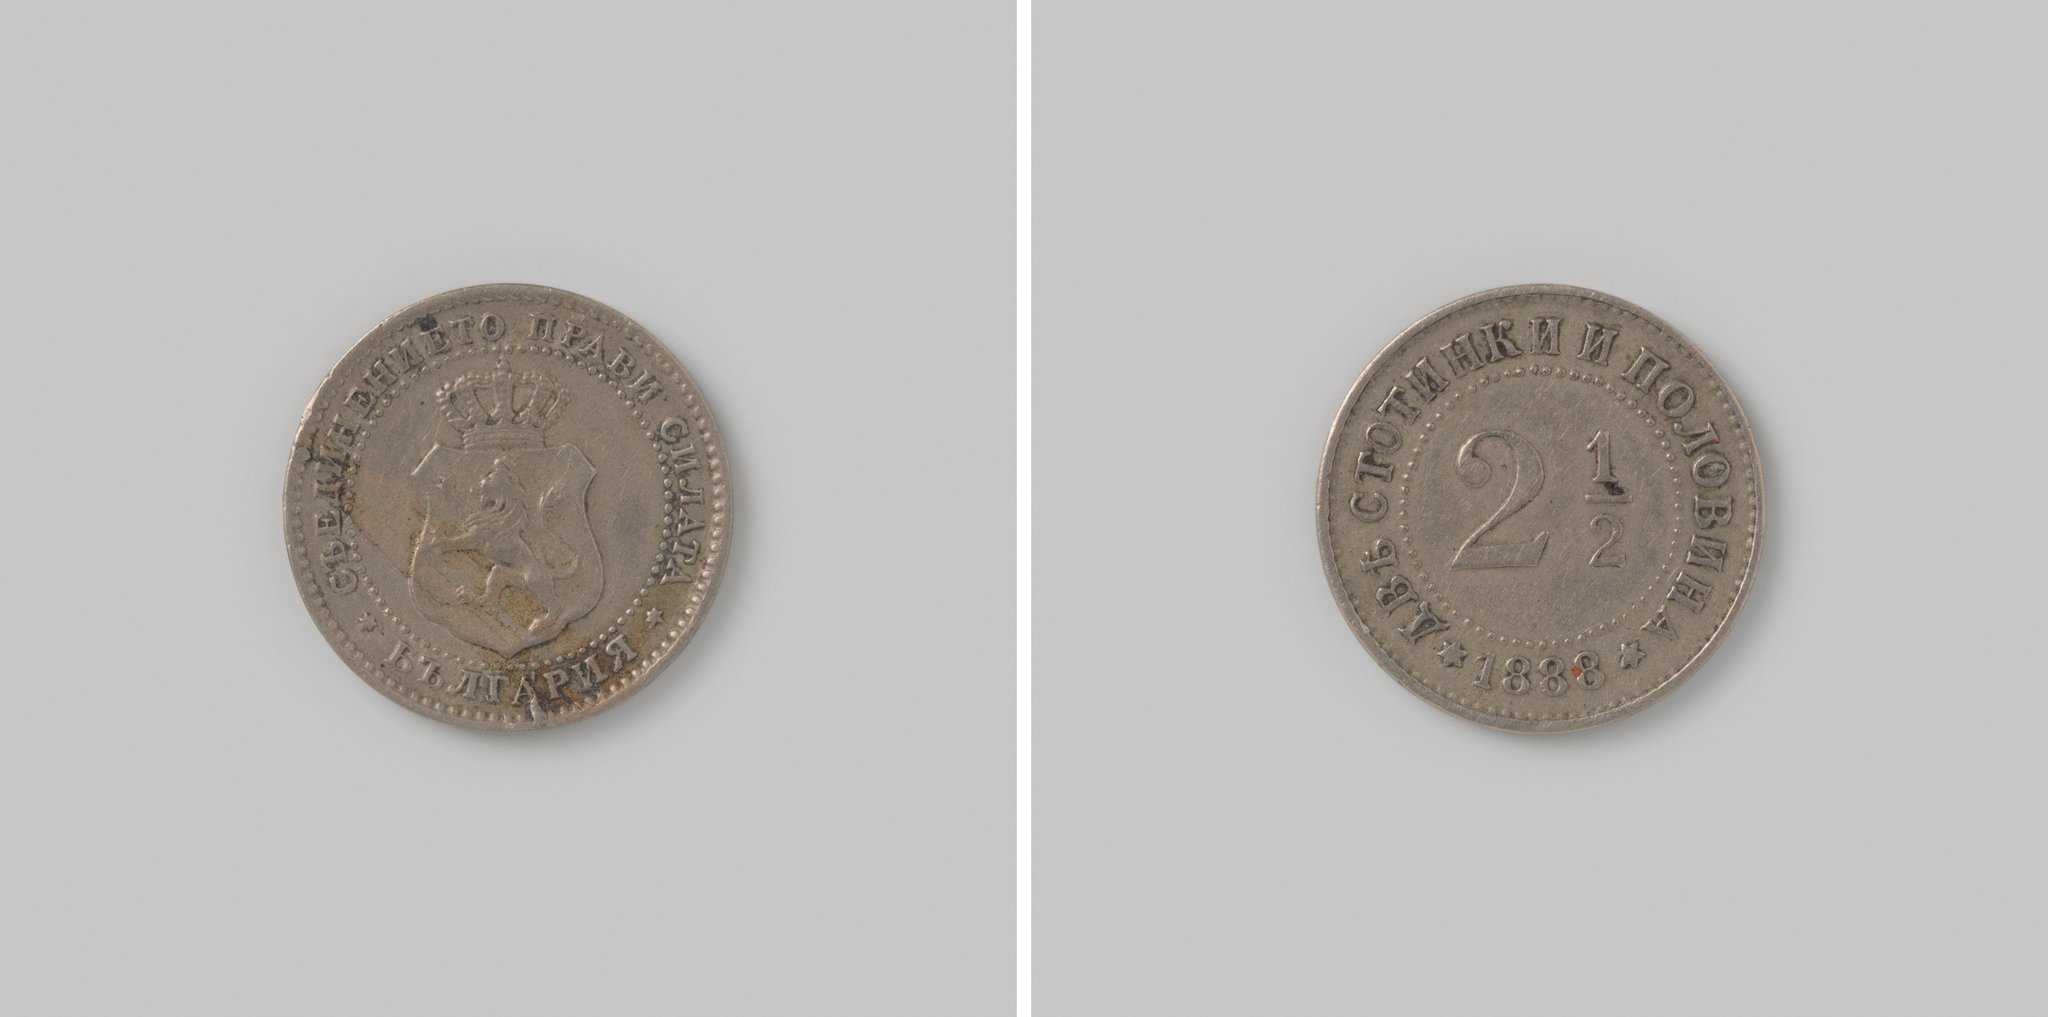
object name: coin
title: 2½ stotinki uit Bulgarije van prins Ferdinand I, 1888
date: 1888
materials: nickel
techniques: striking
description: Koper-nikkelen munt. Voorzijde: gekroond wapenschild. Keerzijde: waarde-aanduiding in een regel. Jaartal in omschrift. Gladde rand.